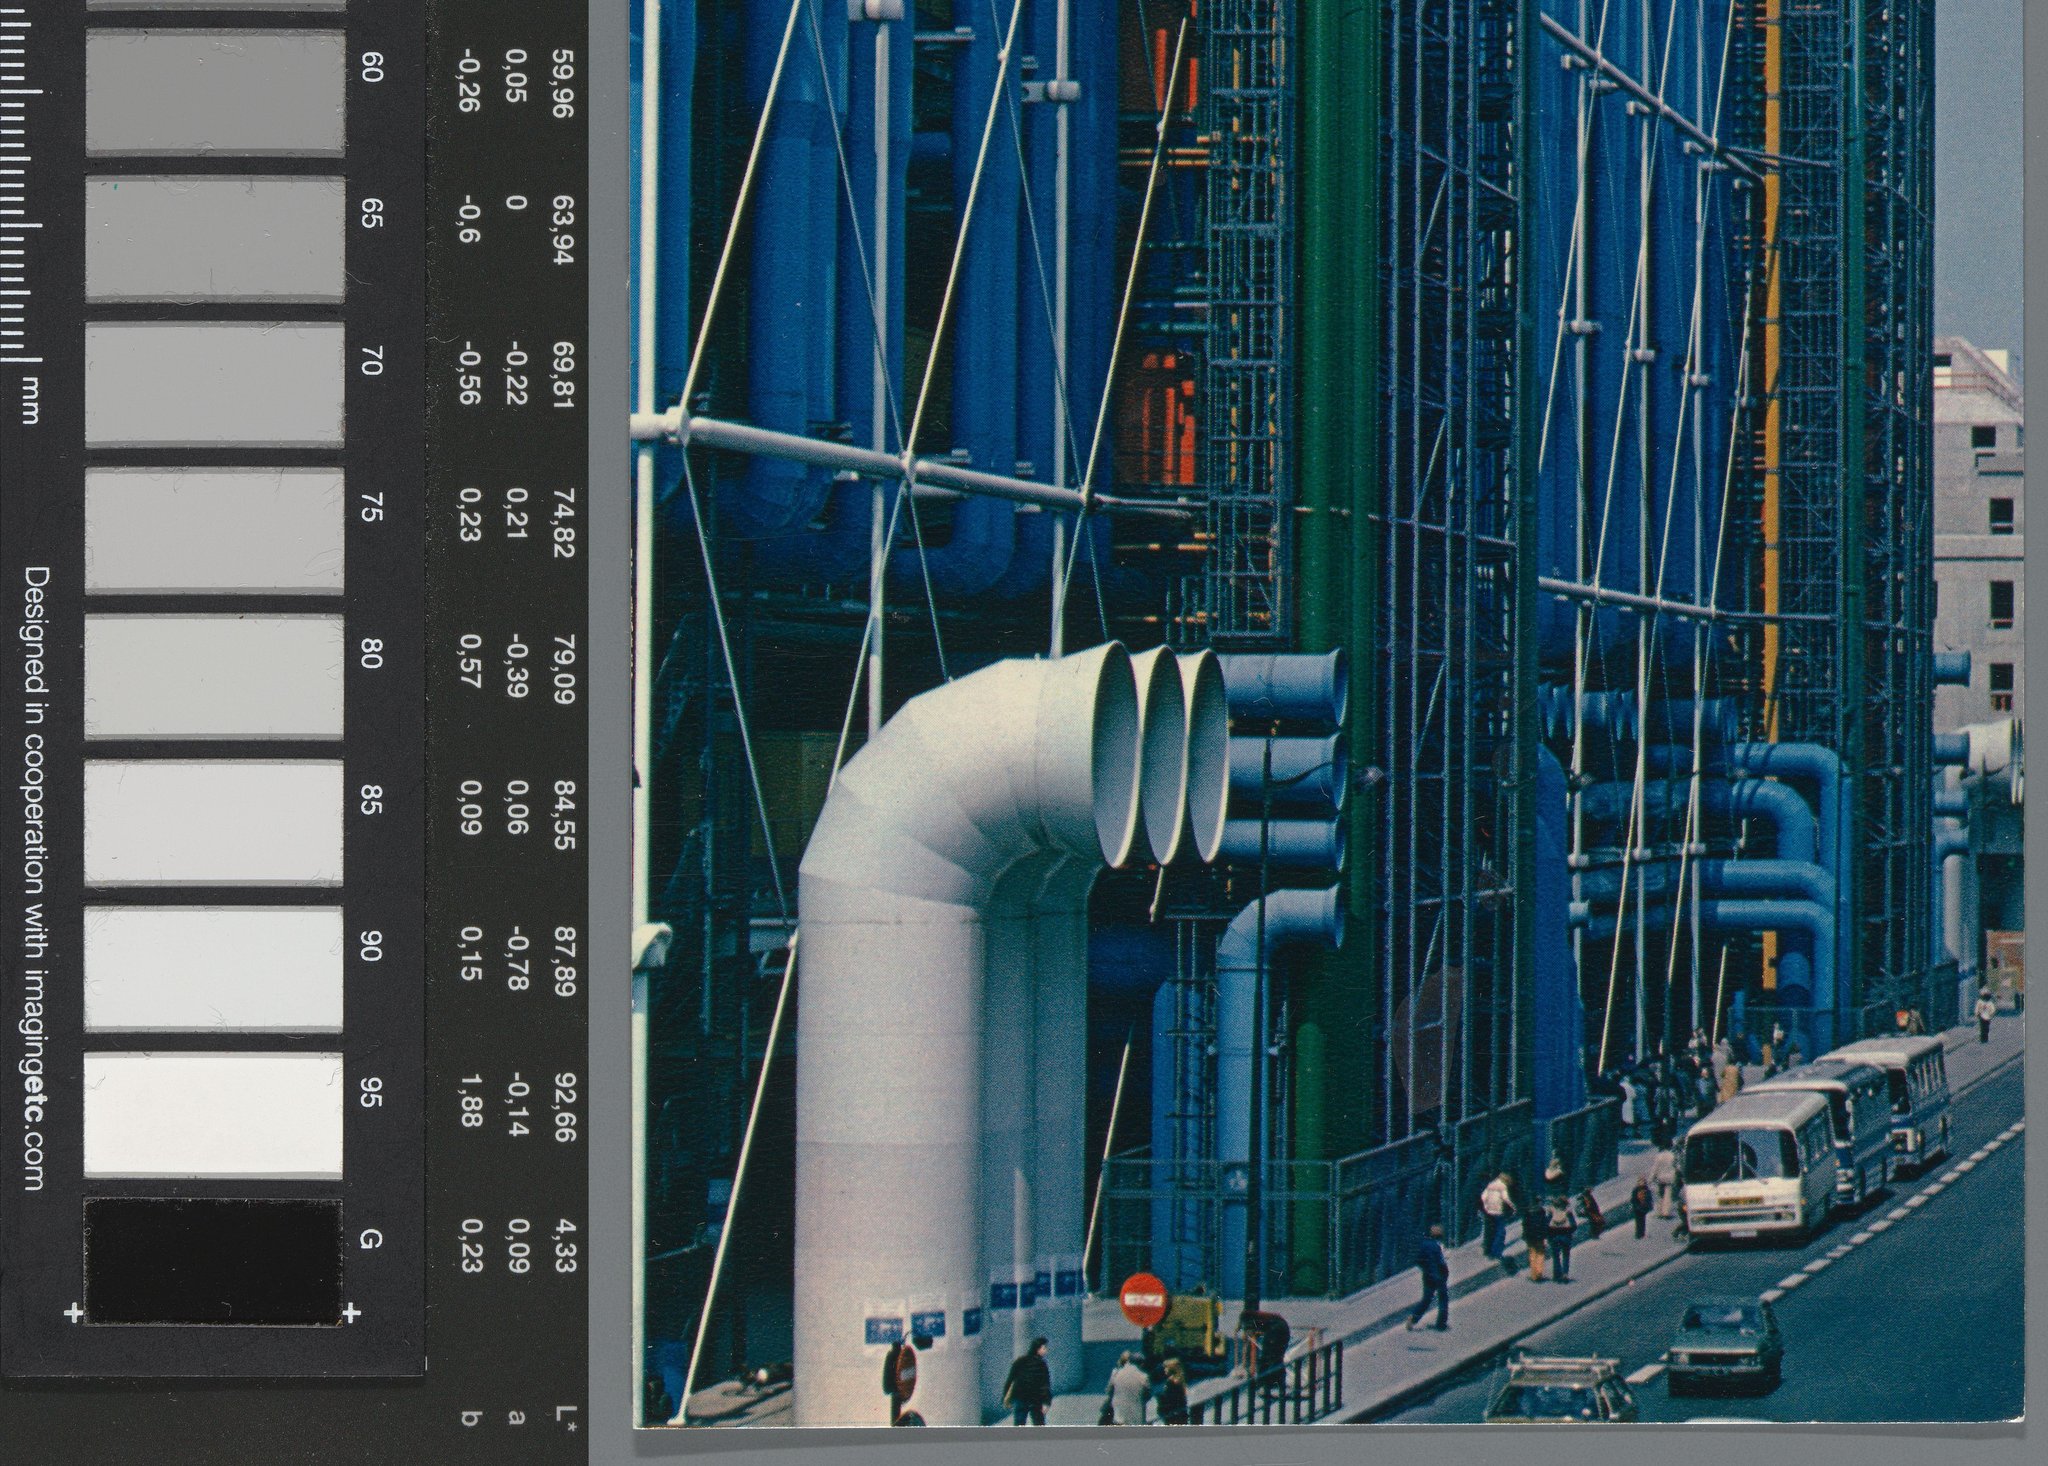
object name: postcard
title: Paris. Centre National dárt et de culture Georges-Pompidou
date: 1920-1950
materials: photographic support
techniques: rotogravure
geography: paris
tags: musée national d'arte moderne centre pompidou